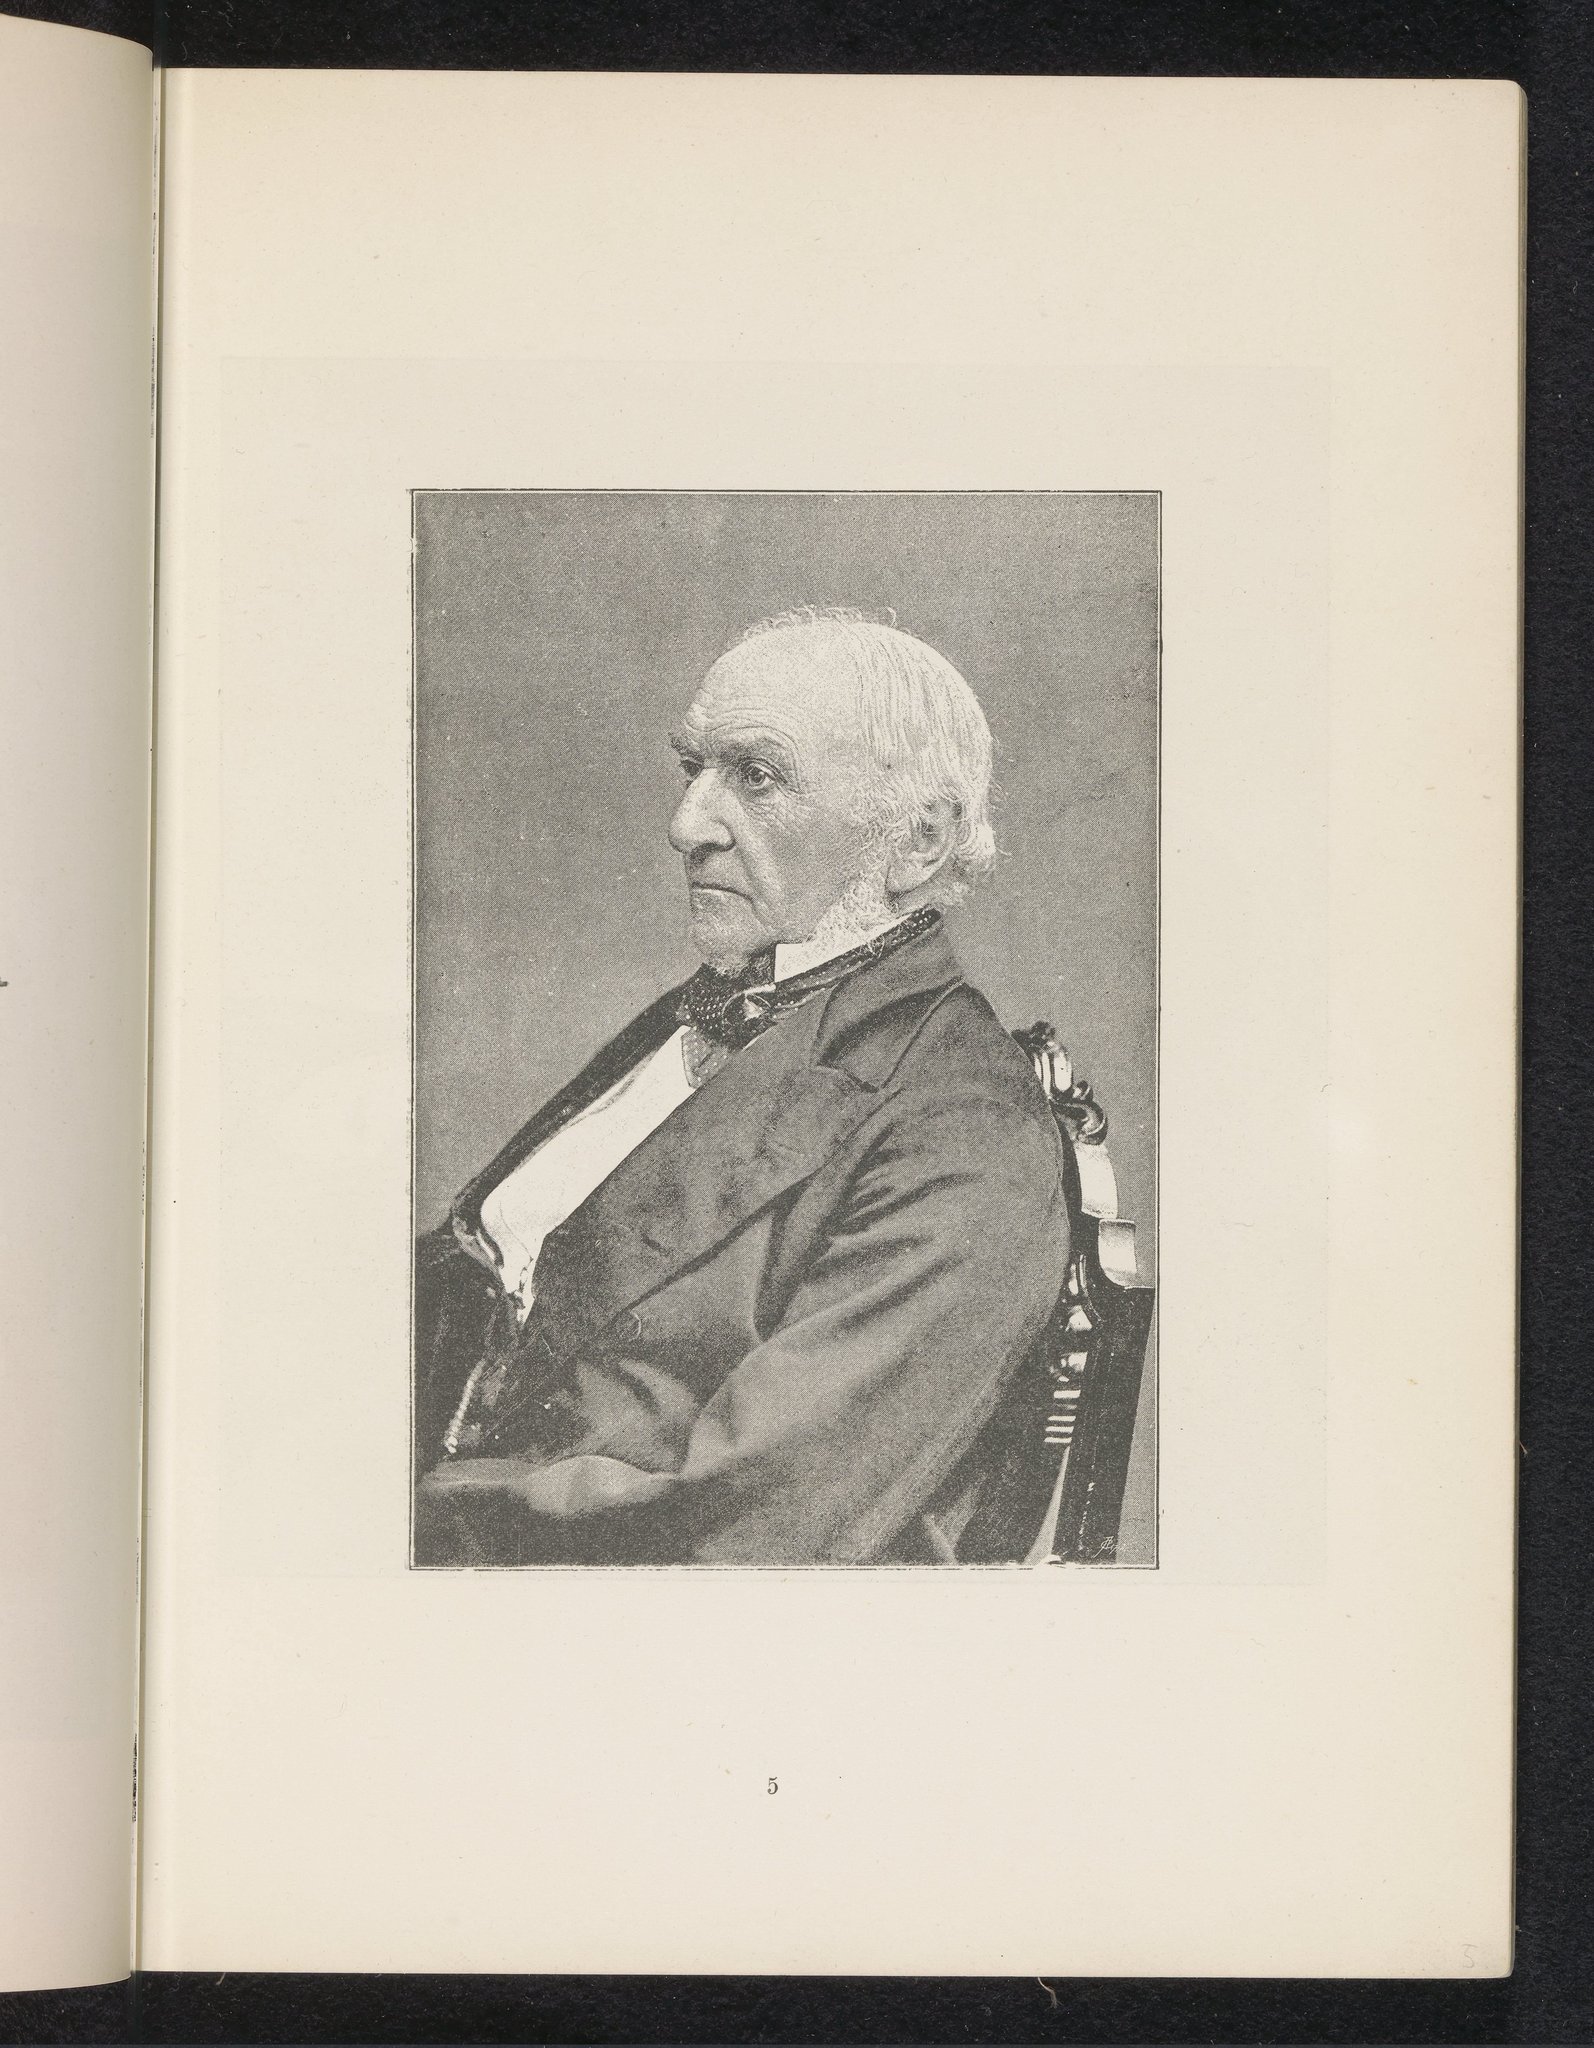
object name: page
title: Portret van William Ewart Gladstone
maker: Anonymous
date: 1881-1891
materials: paper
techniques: autotype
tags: politician, politician, e.g. party leader